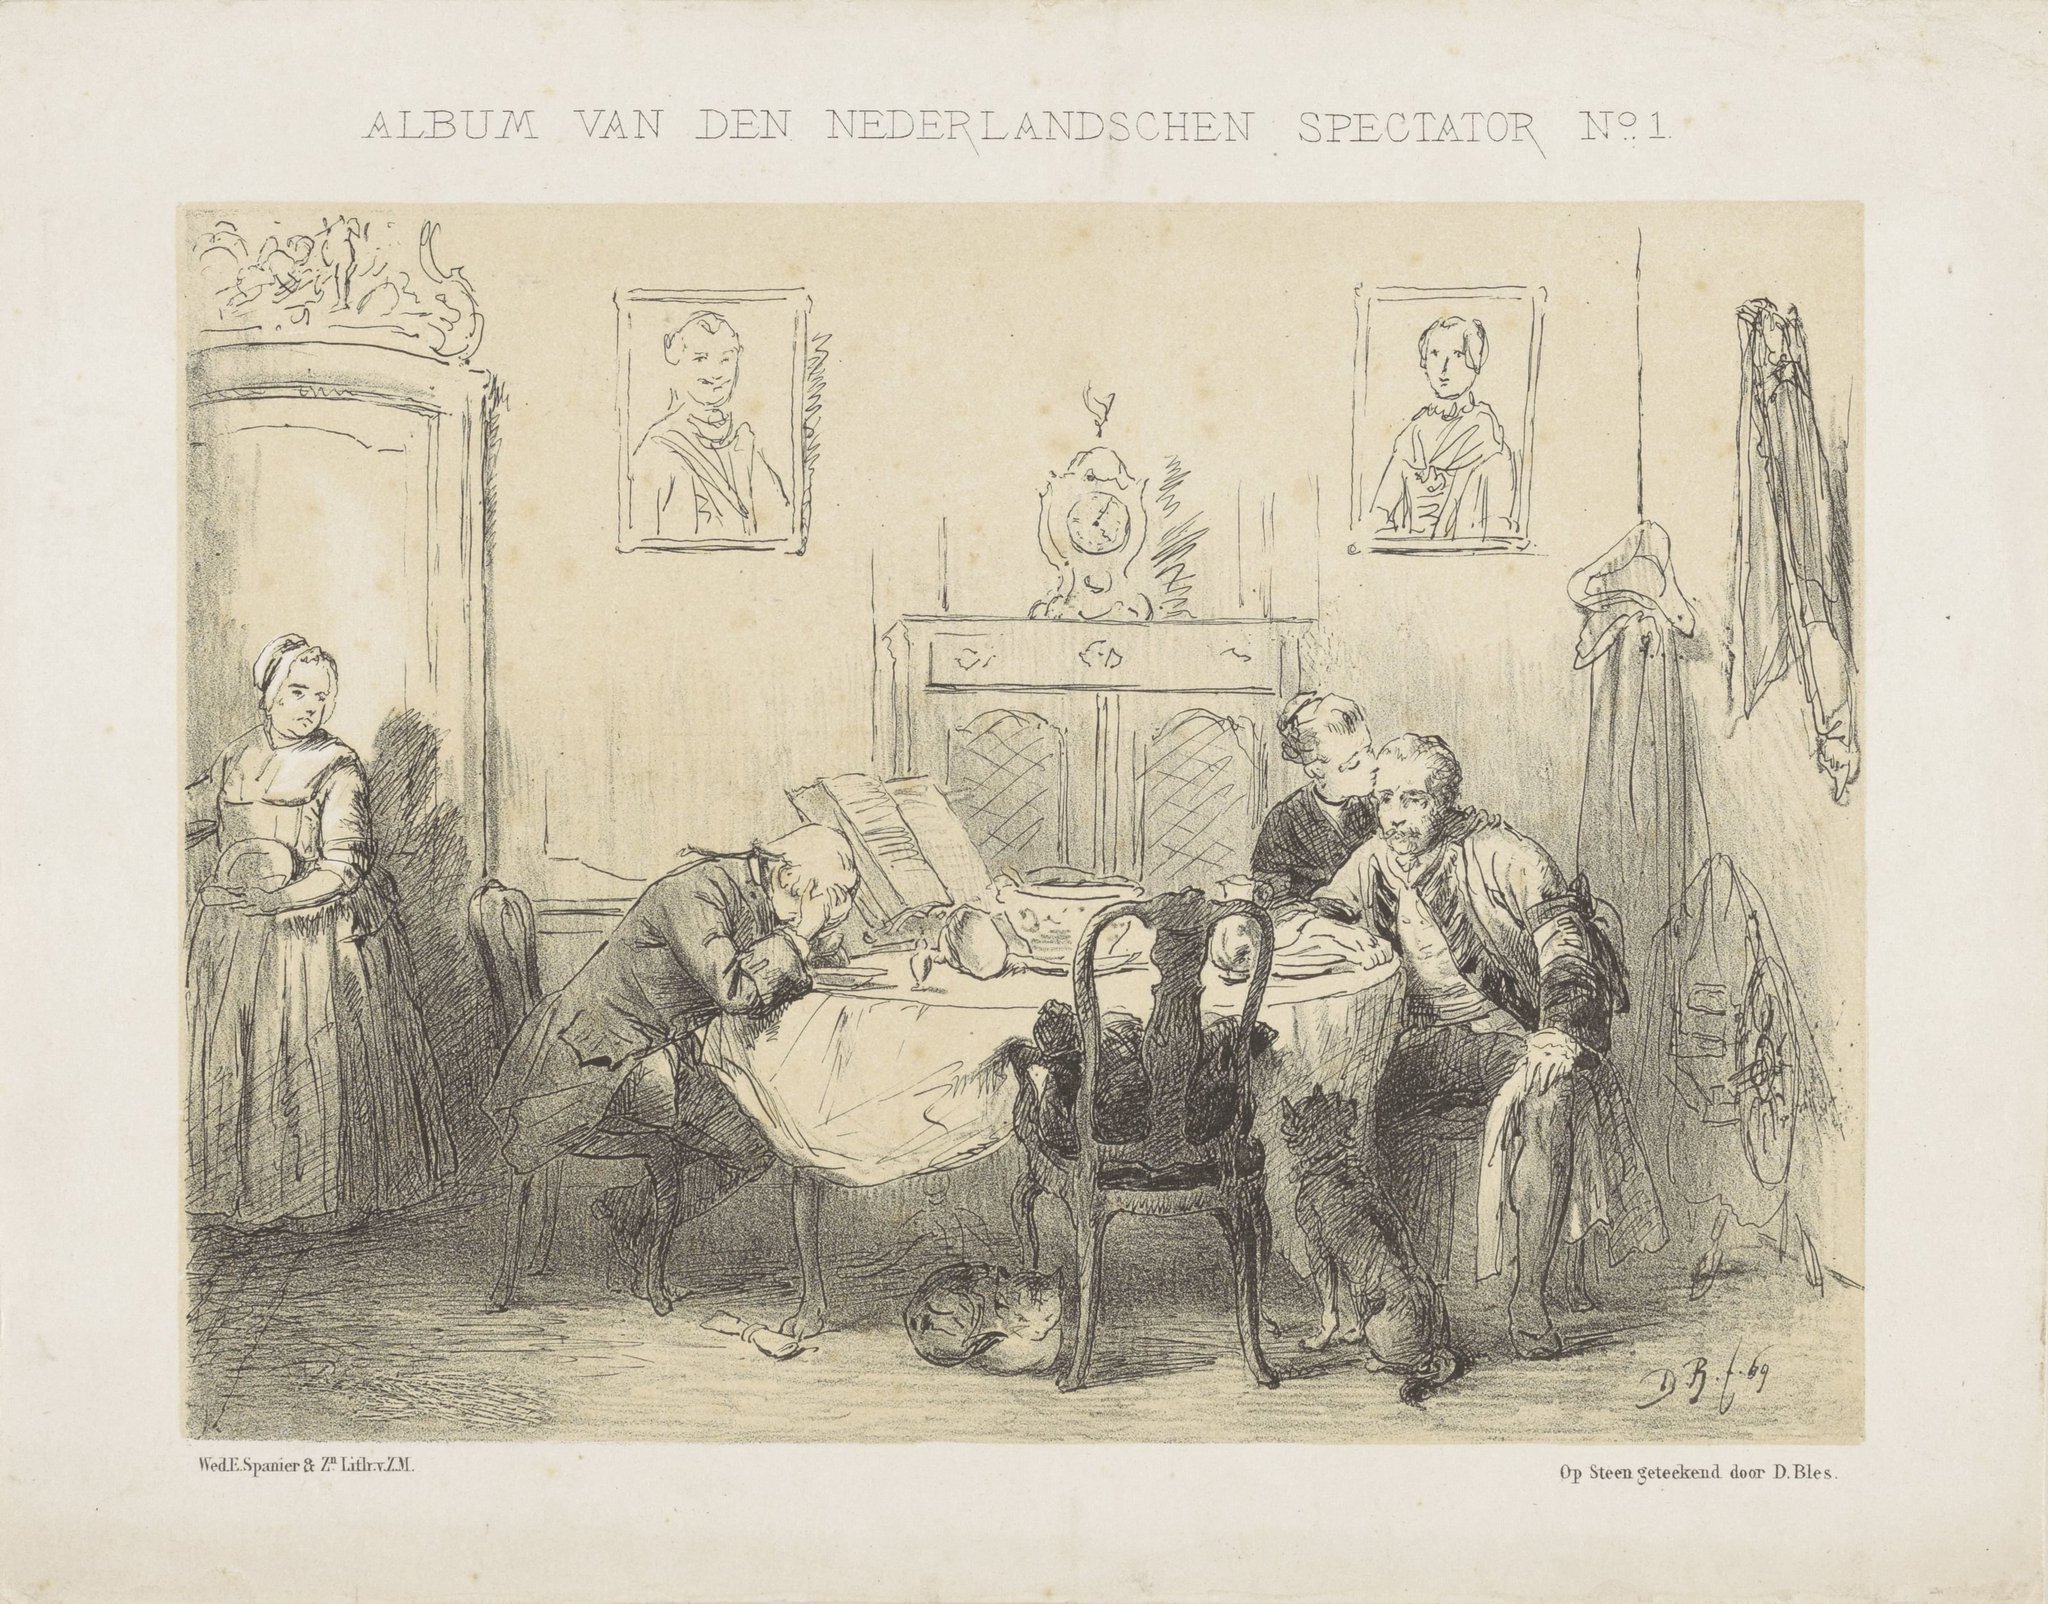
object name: print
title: Album van den Nederlanschen Spectator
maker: david bles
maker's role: draughtsman, painter, print maker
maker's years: 1821-1899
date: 1869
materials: paper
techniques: tone lithography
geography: the hague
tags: mourning customs, weeping, dining-room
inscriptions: collector's mark: Lugt 2228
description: Een gezelschap, aangedaan door verdriet, zit aan tafel. De man rechts staart naar de lege stoel terwijl zijn vrouw hem kust. De man aan de andere kant van de tafel heeft zijn handen voor het gezicht. In de deuropening staat een bediende. Boven de afbeelding staat: 'Album van den Nederlandschen Spectator No.1'